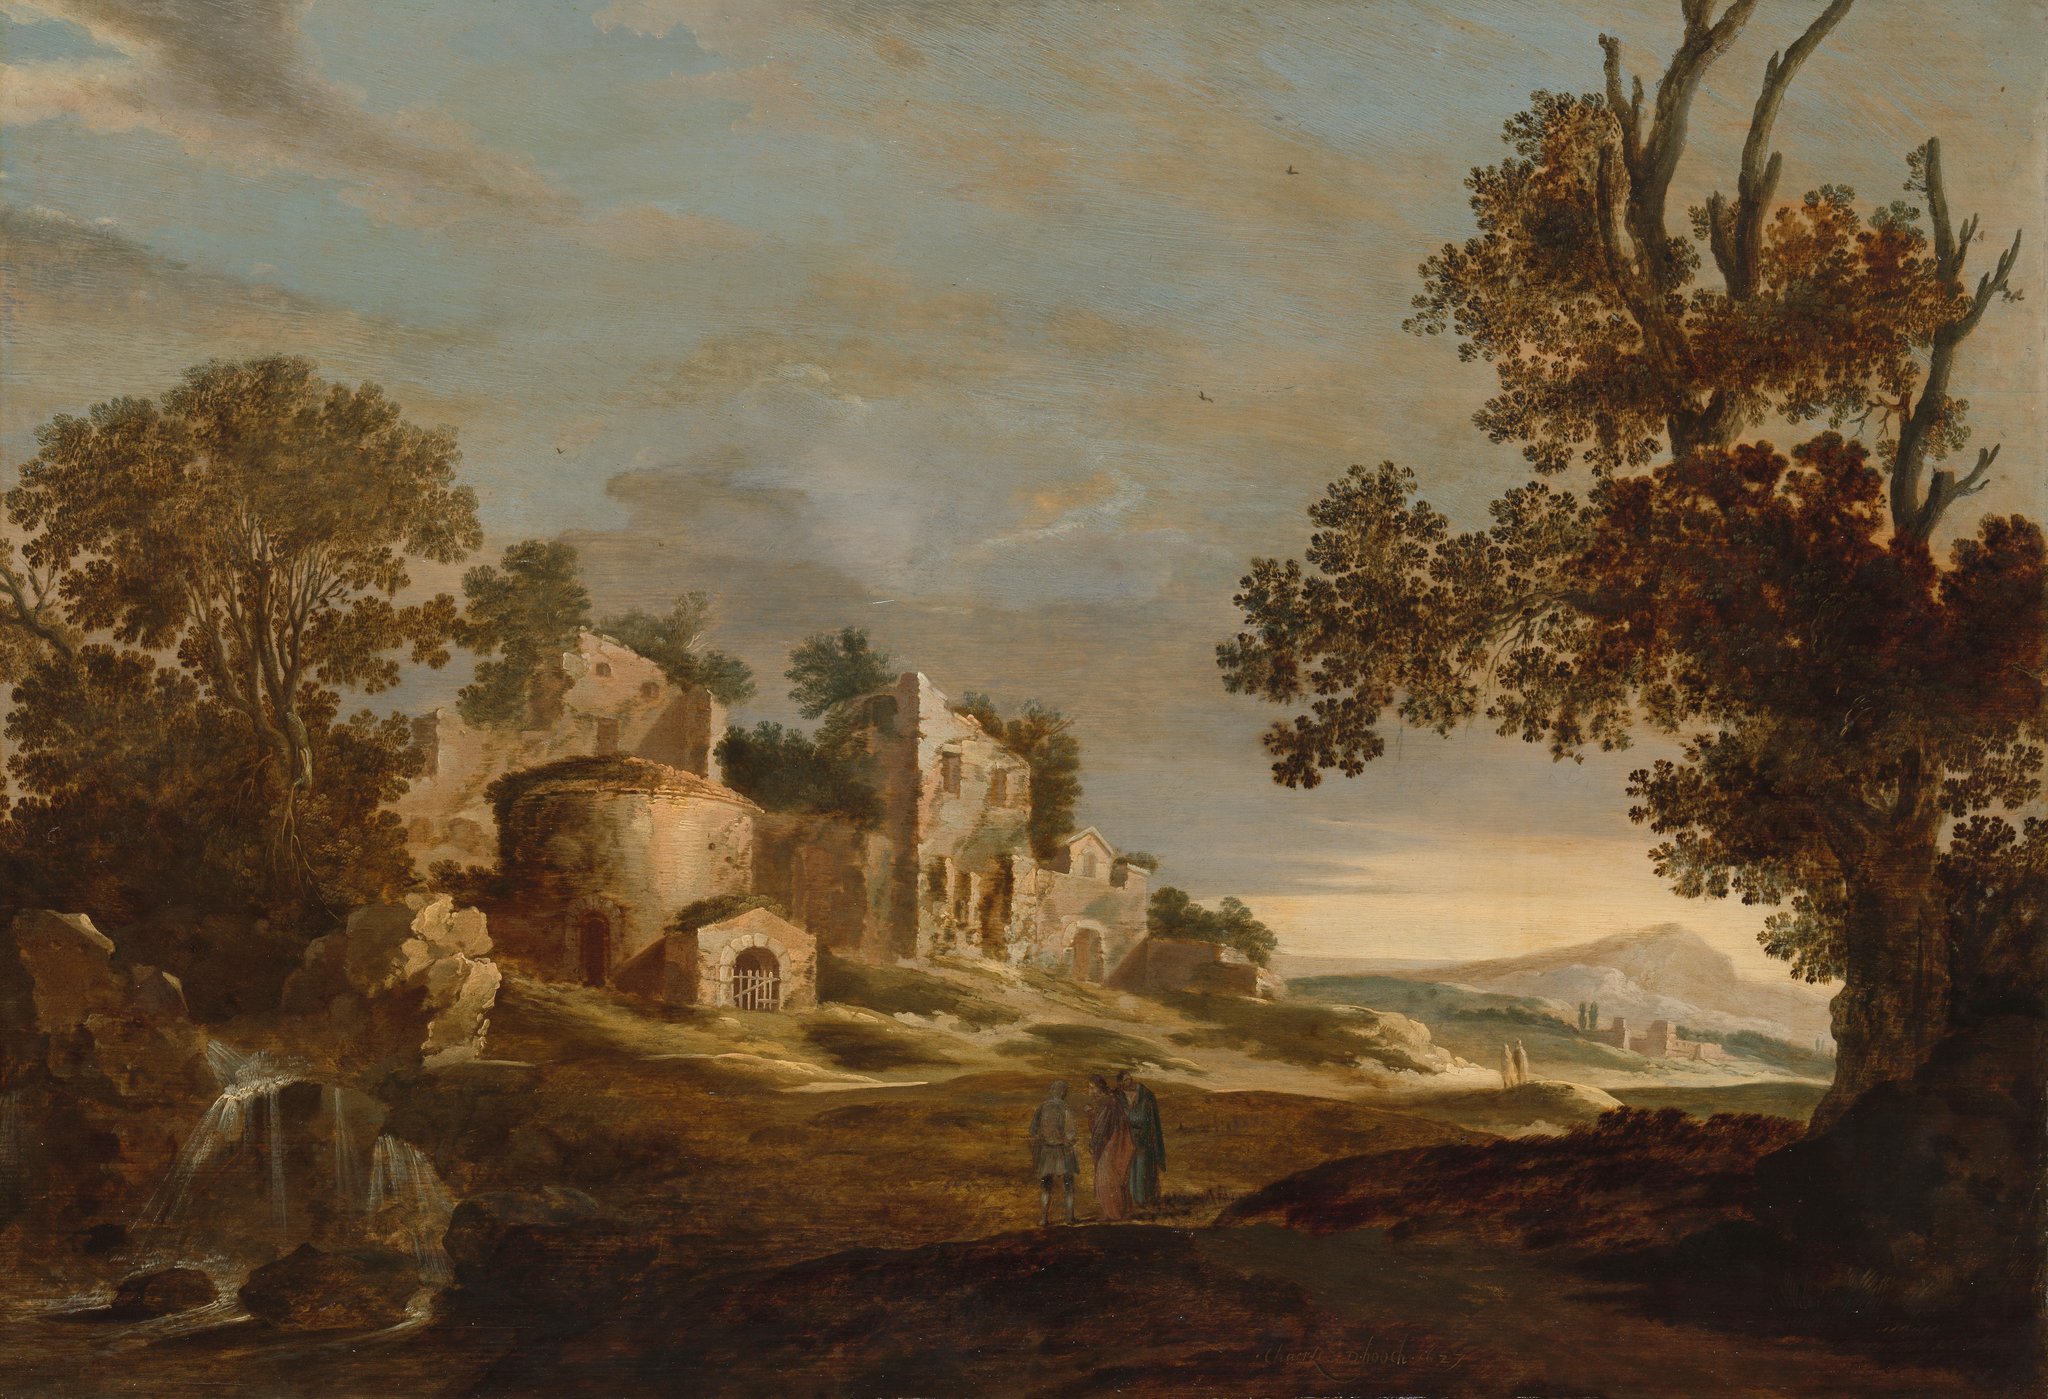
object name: painting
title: Landscape with Journey to Emmaus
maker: chaerles de hooch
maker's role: painter, print maker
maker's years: 1600-1638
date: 1627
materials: oil, panel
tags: the journey to emmaus: two disciples (cleopas and peter) under way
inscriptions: signature and date: ‘Chaerles D. hooch. 1627’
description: Landschap met de Emmaüsgangers. Heuvellandschap met links enkele vervallen gebouwen, op de voorgrond een watervalletje. Rechts een oude boom.